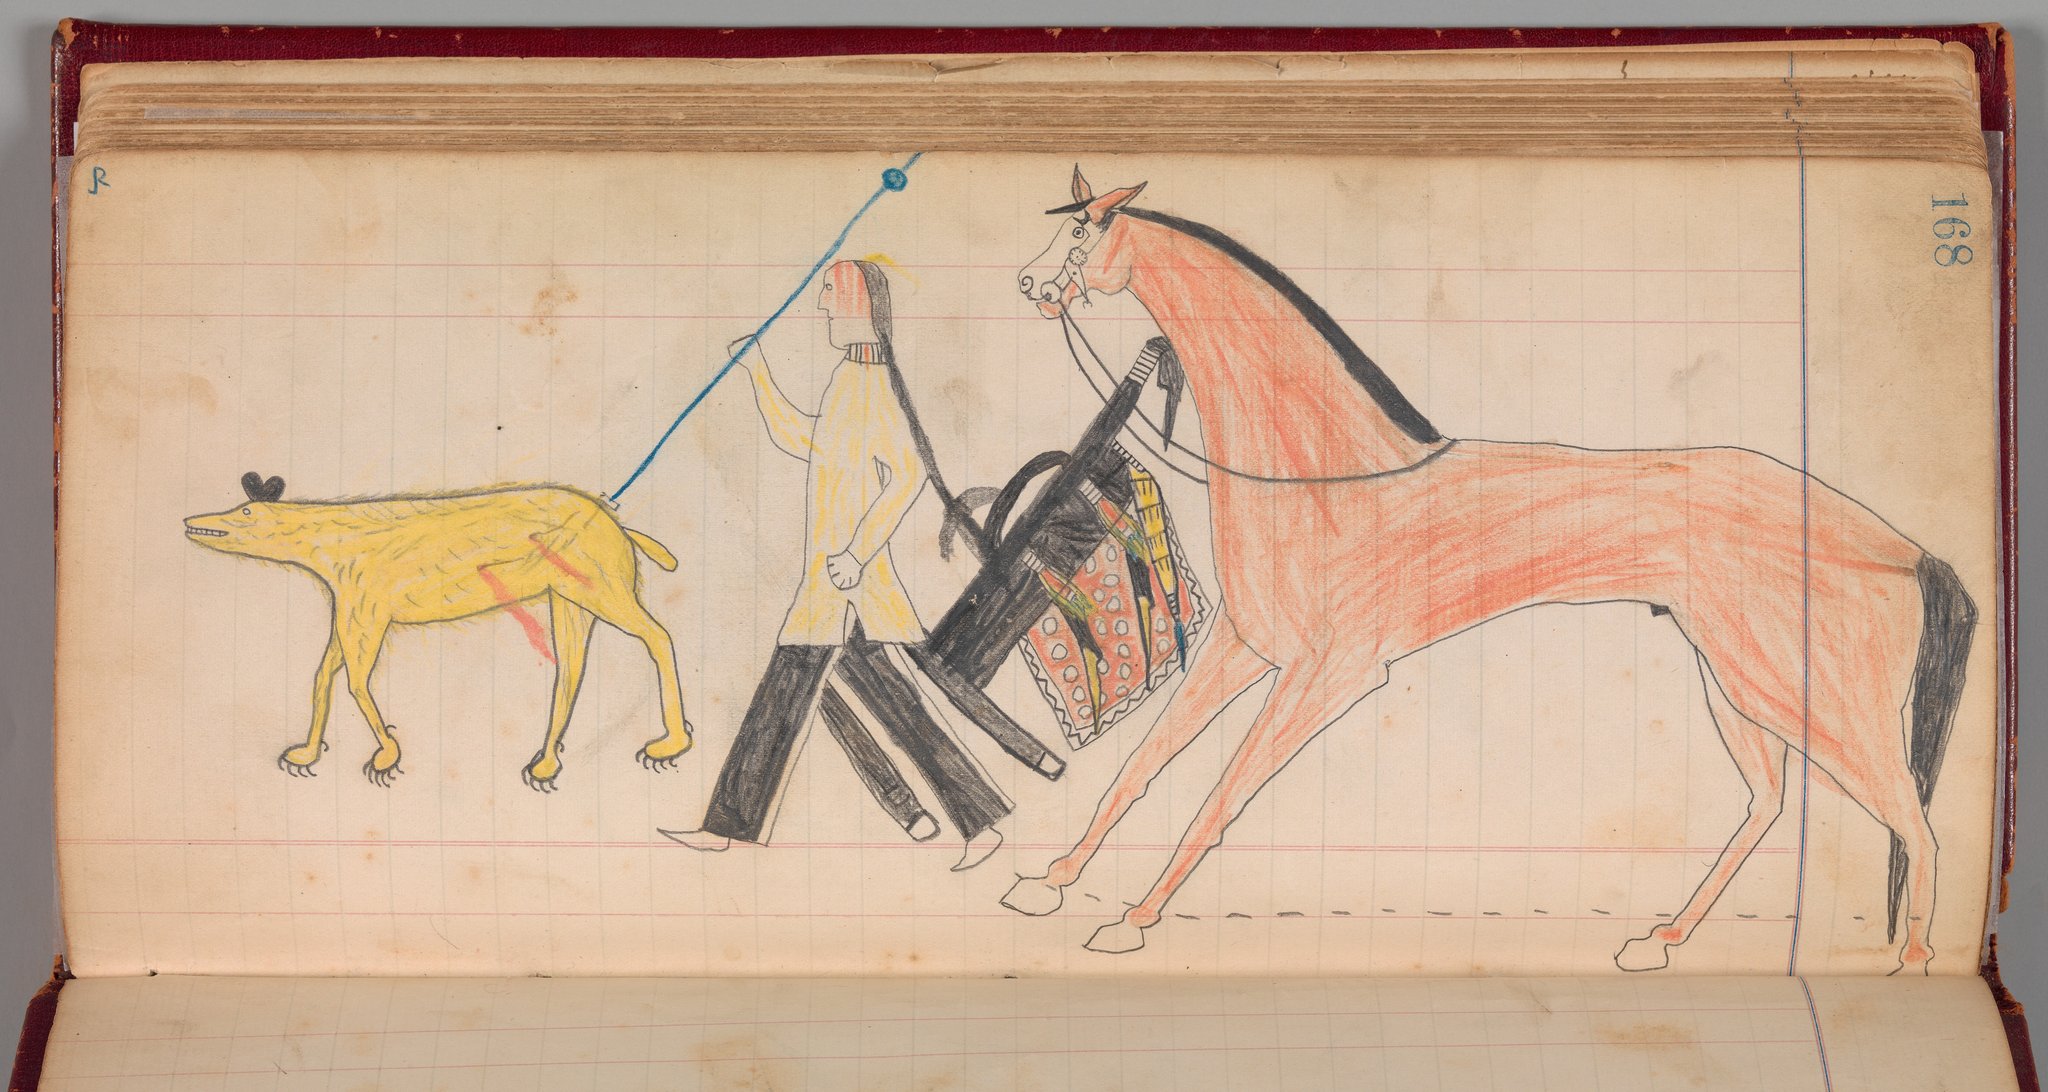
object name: drawing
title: Maffet Ledger: Drawing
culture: cheyenne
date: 1874-1881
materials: crayon, graphite, paper, watercolor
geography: united states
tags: men,horses